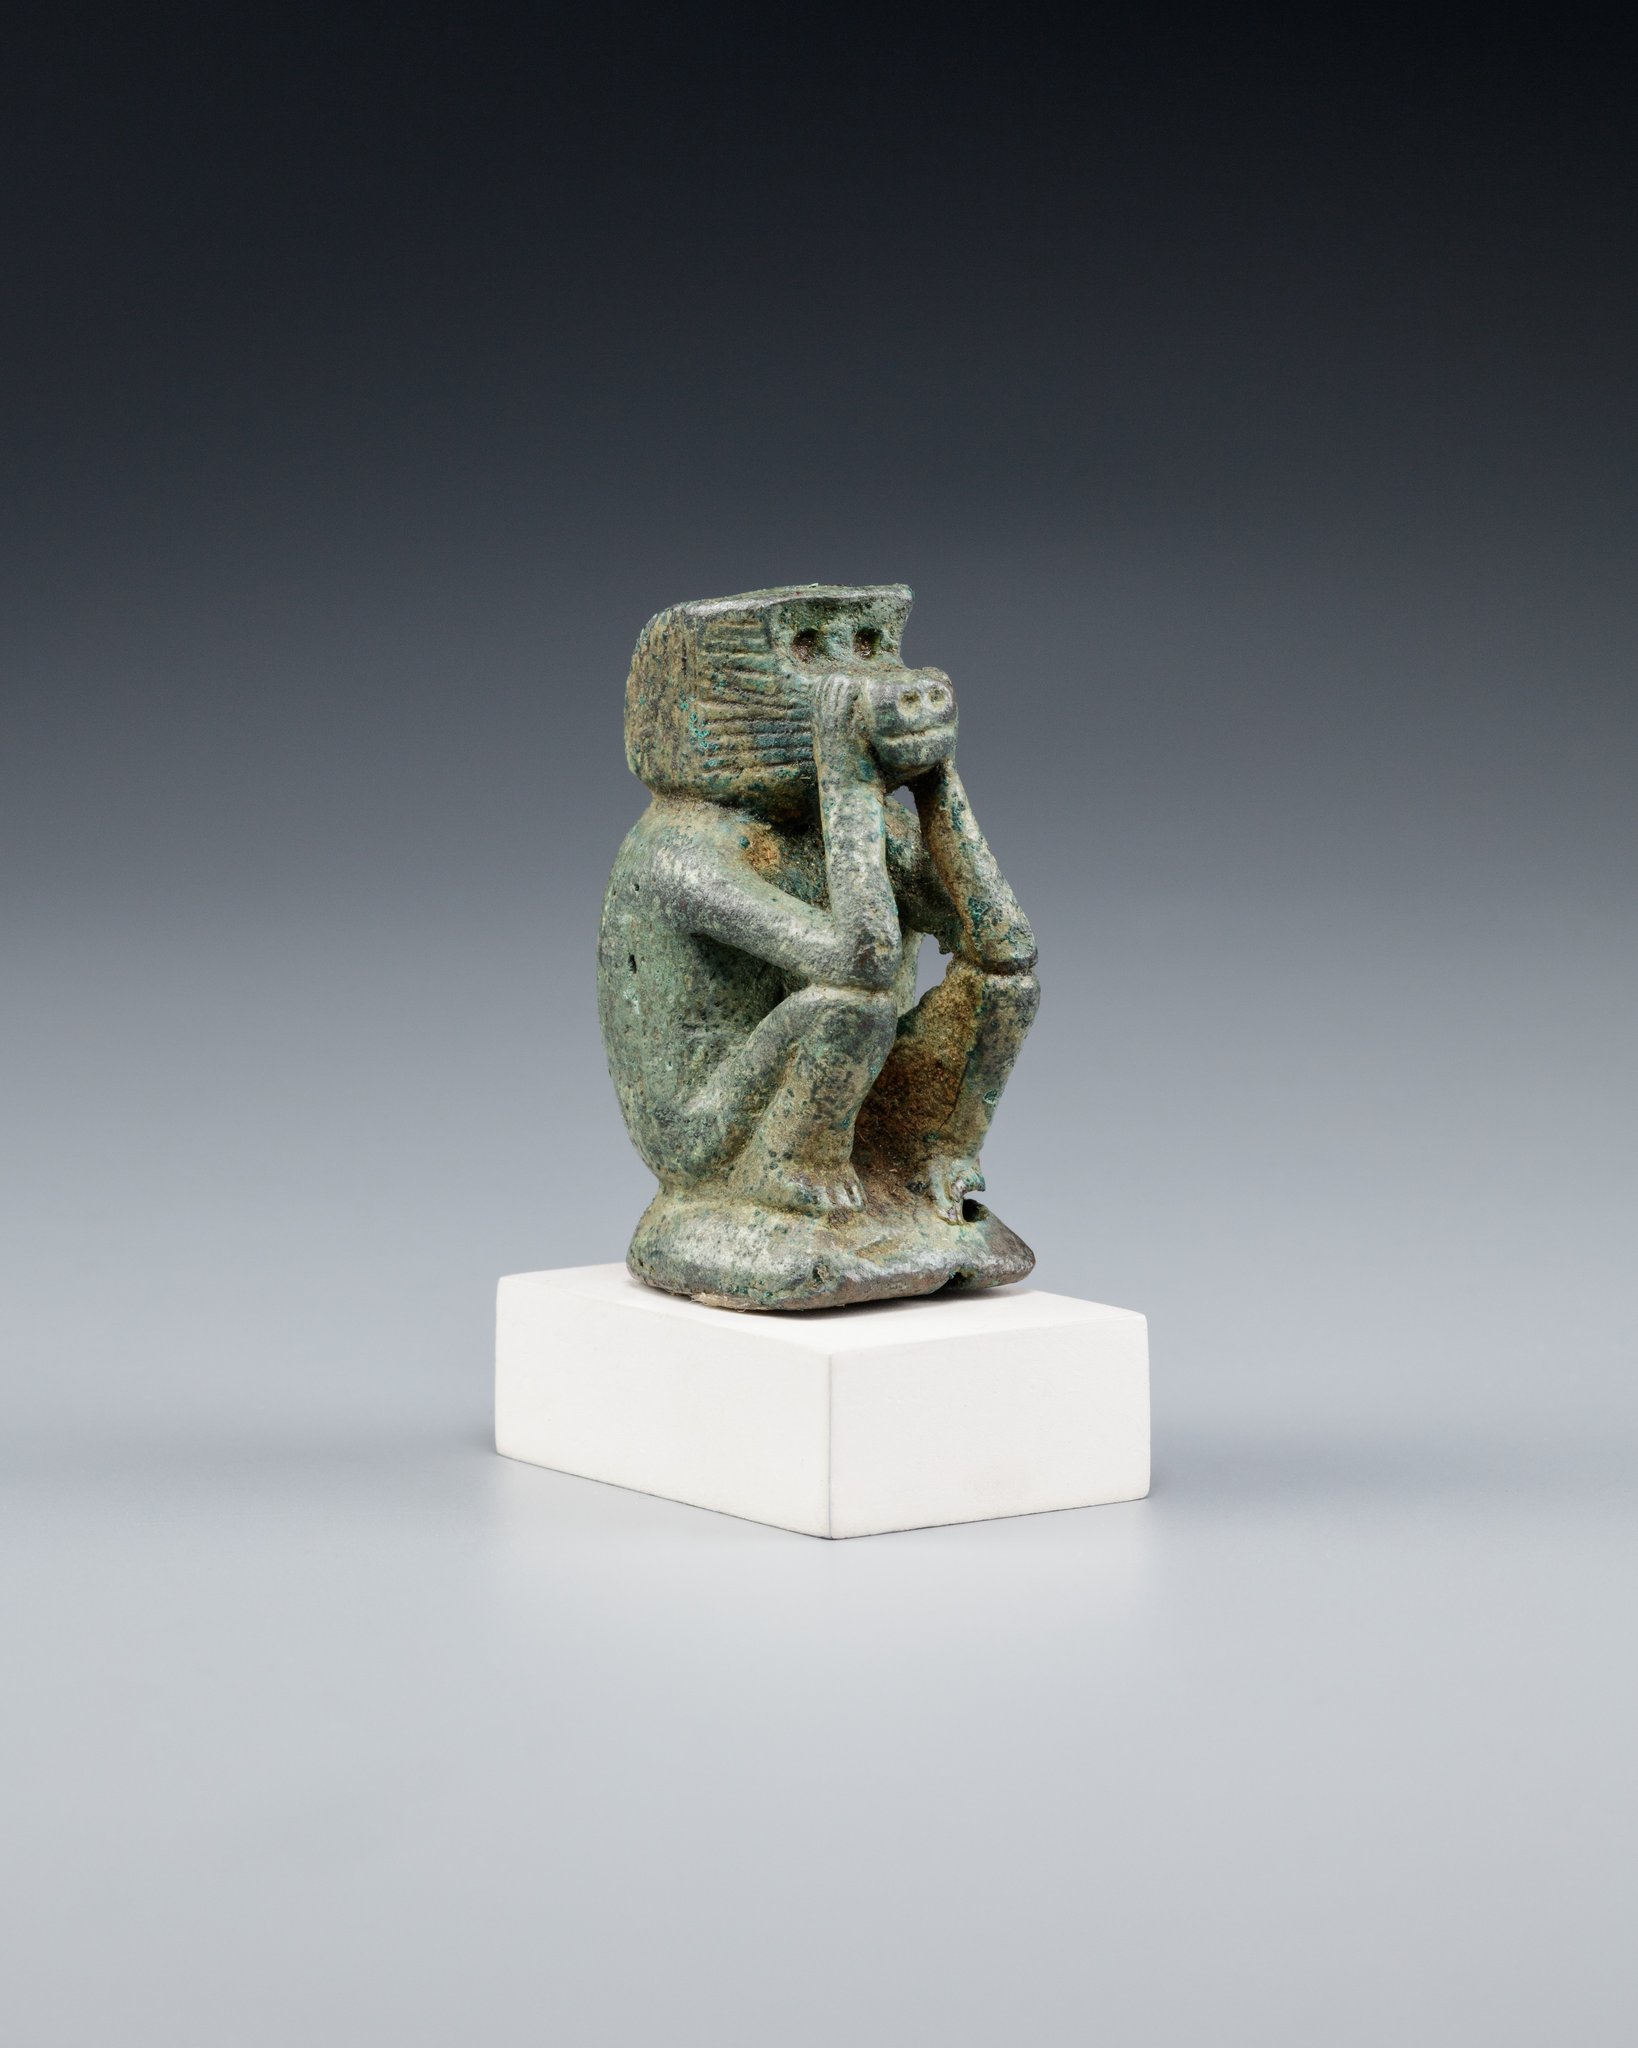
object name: figurine, cynocephalus ape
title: Figure of a squatting cynocephalus ape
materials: bronze, copper alloy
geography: memphite region